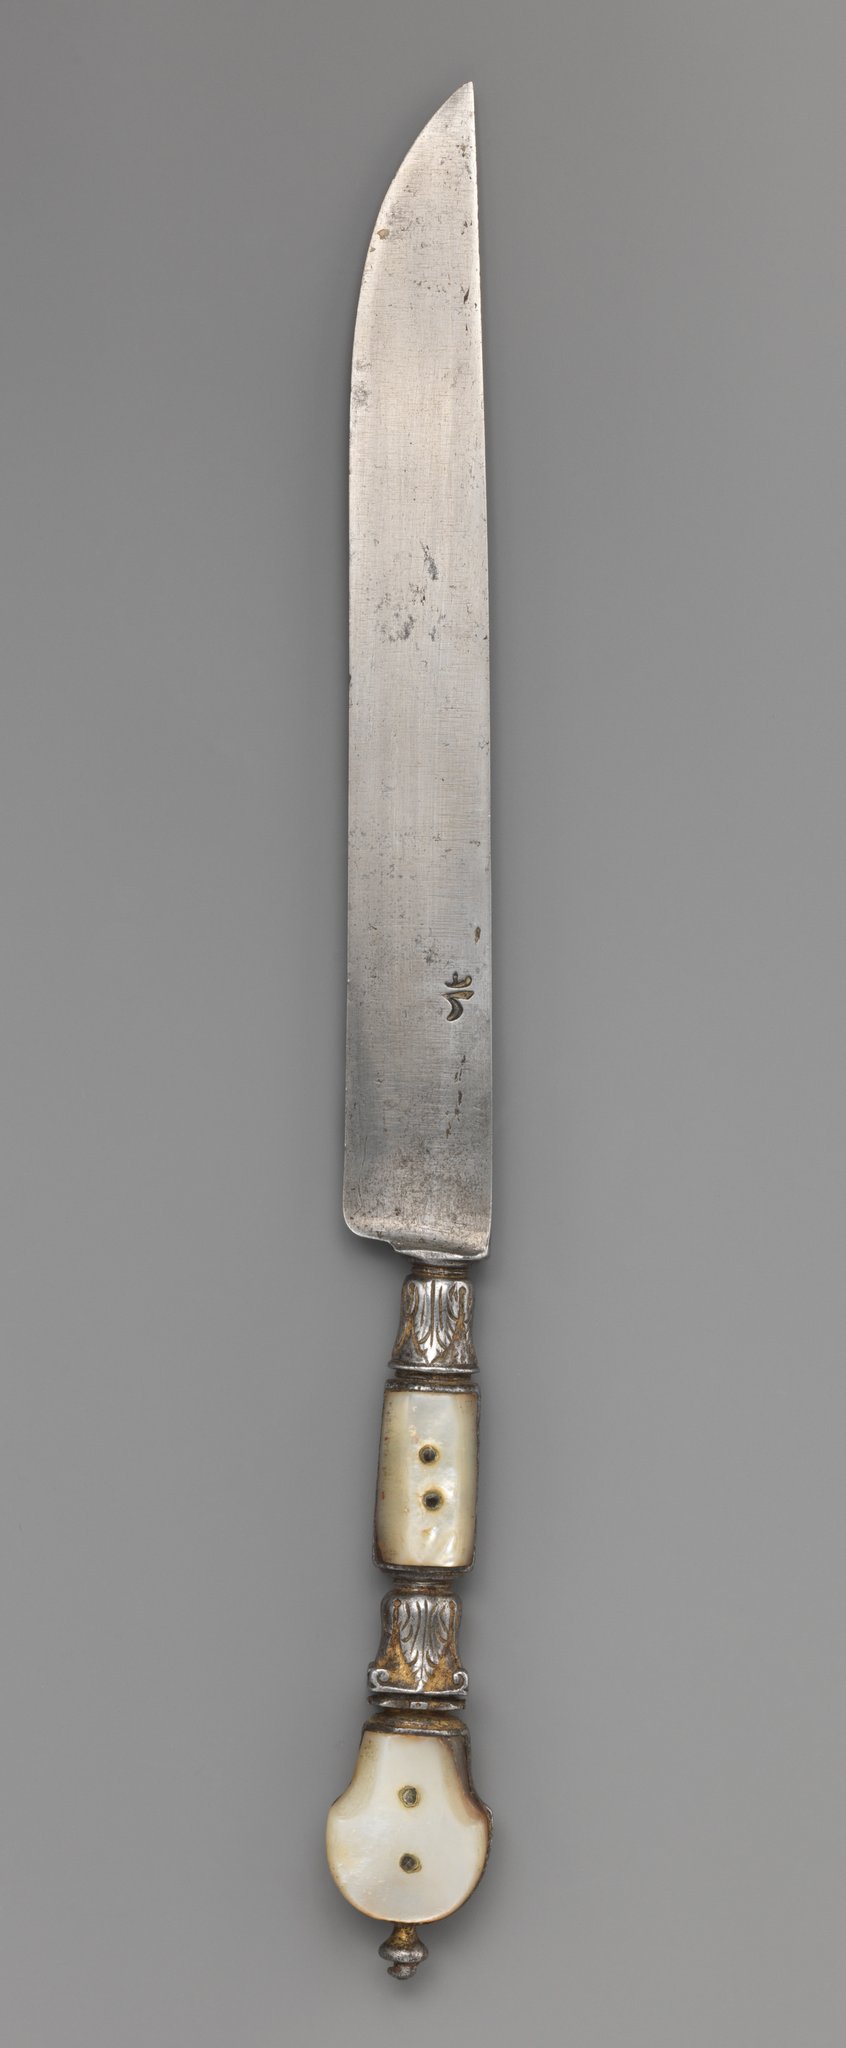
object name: bread knife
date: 1567-1600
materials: bronze, gilt bronze, mother of pearl, steel